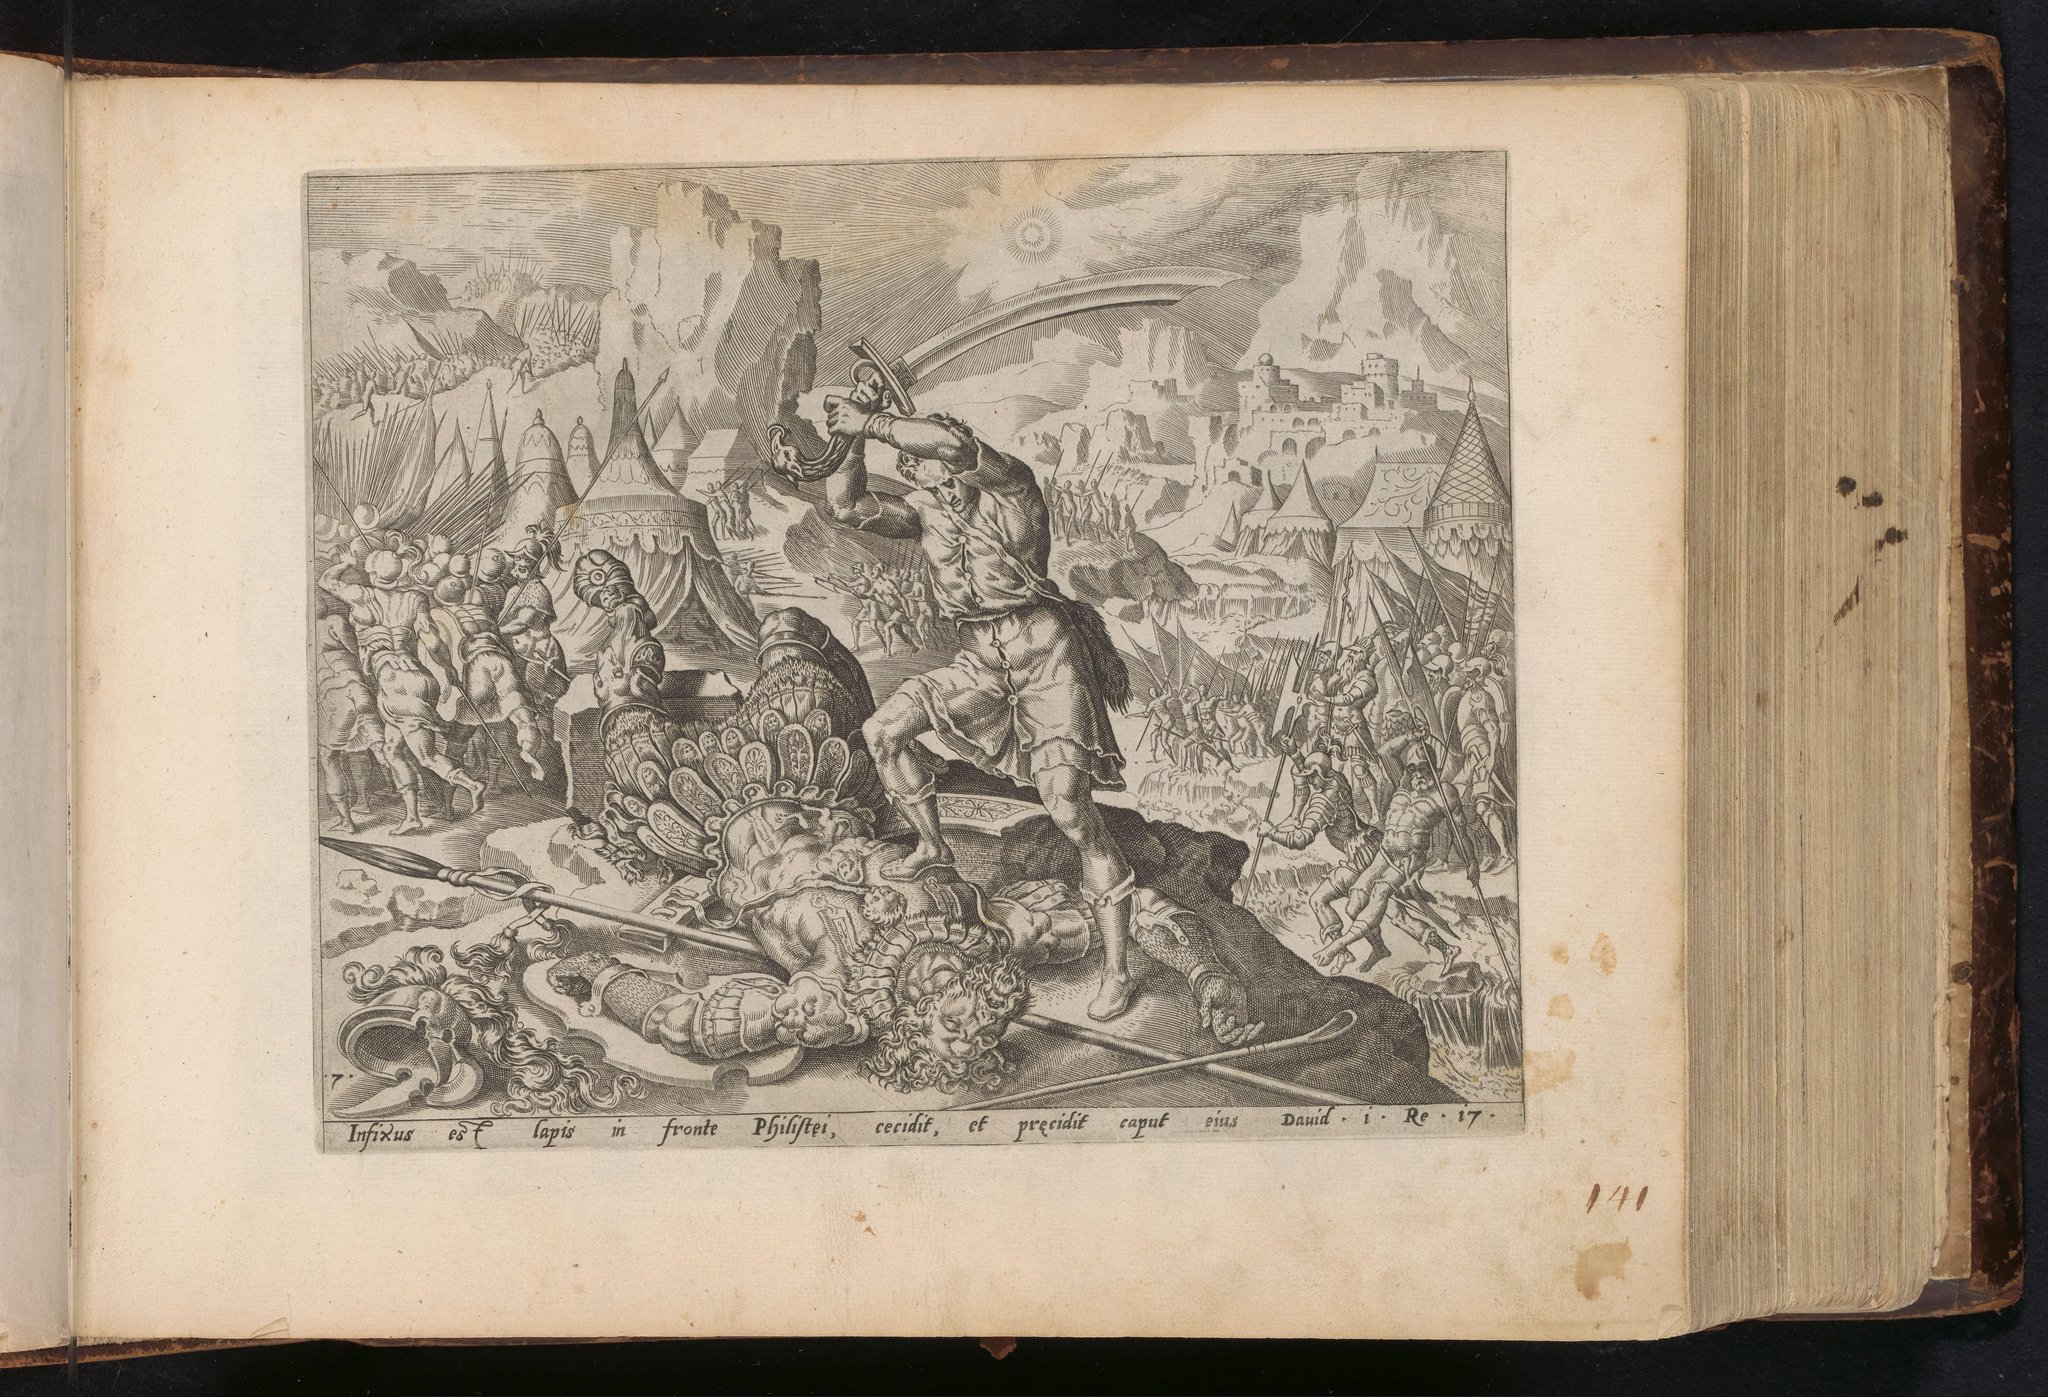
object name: album leaf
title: David onthoofdt Goliat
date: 1554-1558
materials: paper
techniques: engraving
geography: amsterdam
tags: david beheads goliath with a sword, the philistines in flight after the death of goliath are pursued by the israelites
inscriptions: number: ‘141’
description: Goliat ligt op de grond. David staat met één voet op zijn borst en heft het zwaard van Goliat boven zijn hoofd, klaar om hem te onthoofden. Links vluchten de Filistijnen, terwijl de soldaten van Saul de achtervolging inzetten. Onder de voorstelling een verwijzing in het Latijn naar de Bijbeltekst in 1 Sam. 17. Deze prent maakt deel uit van een album.